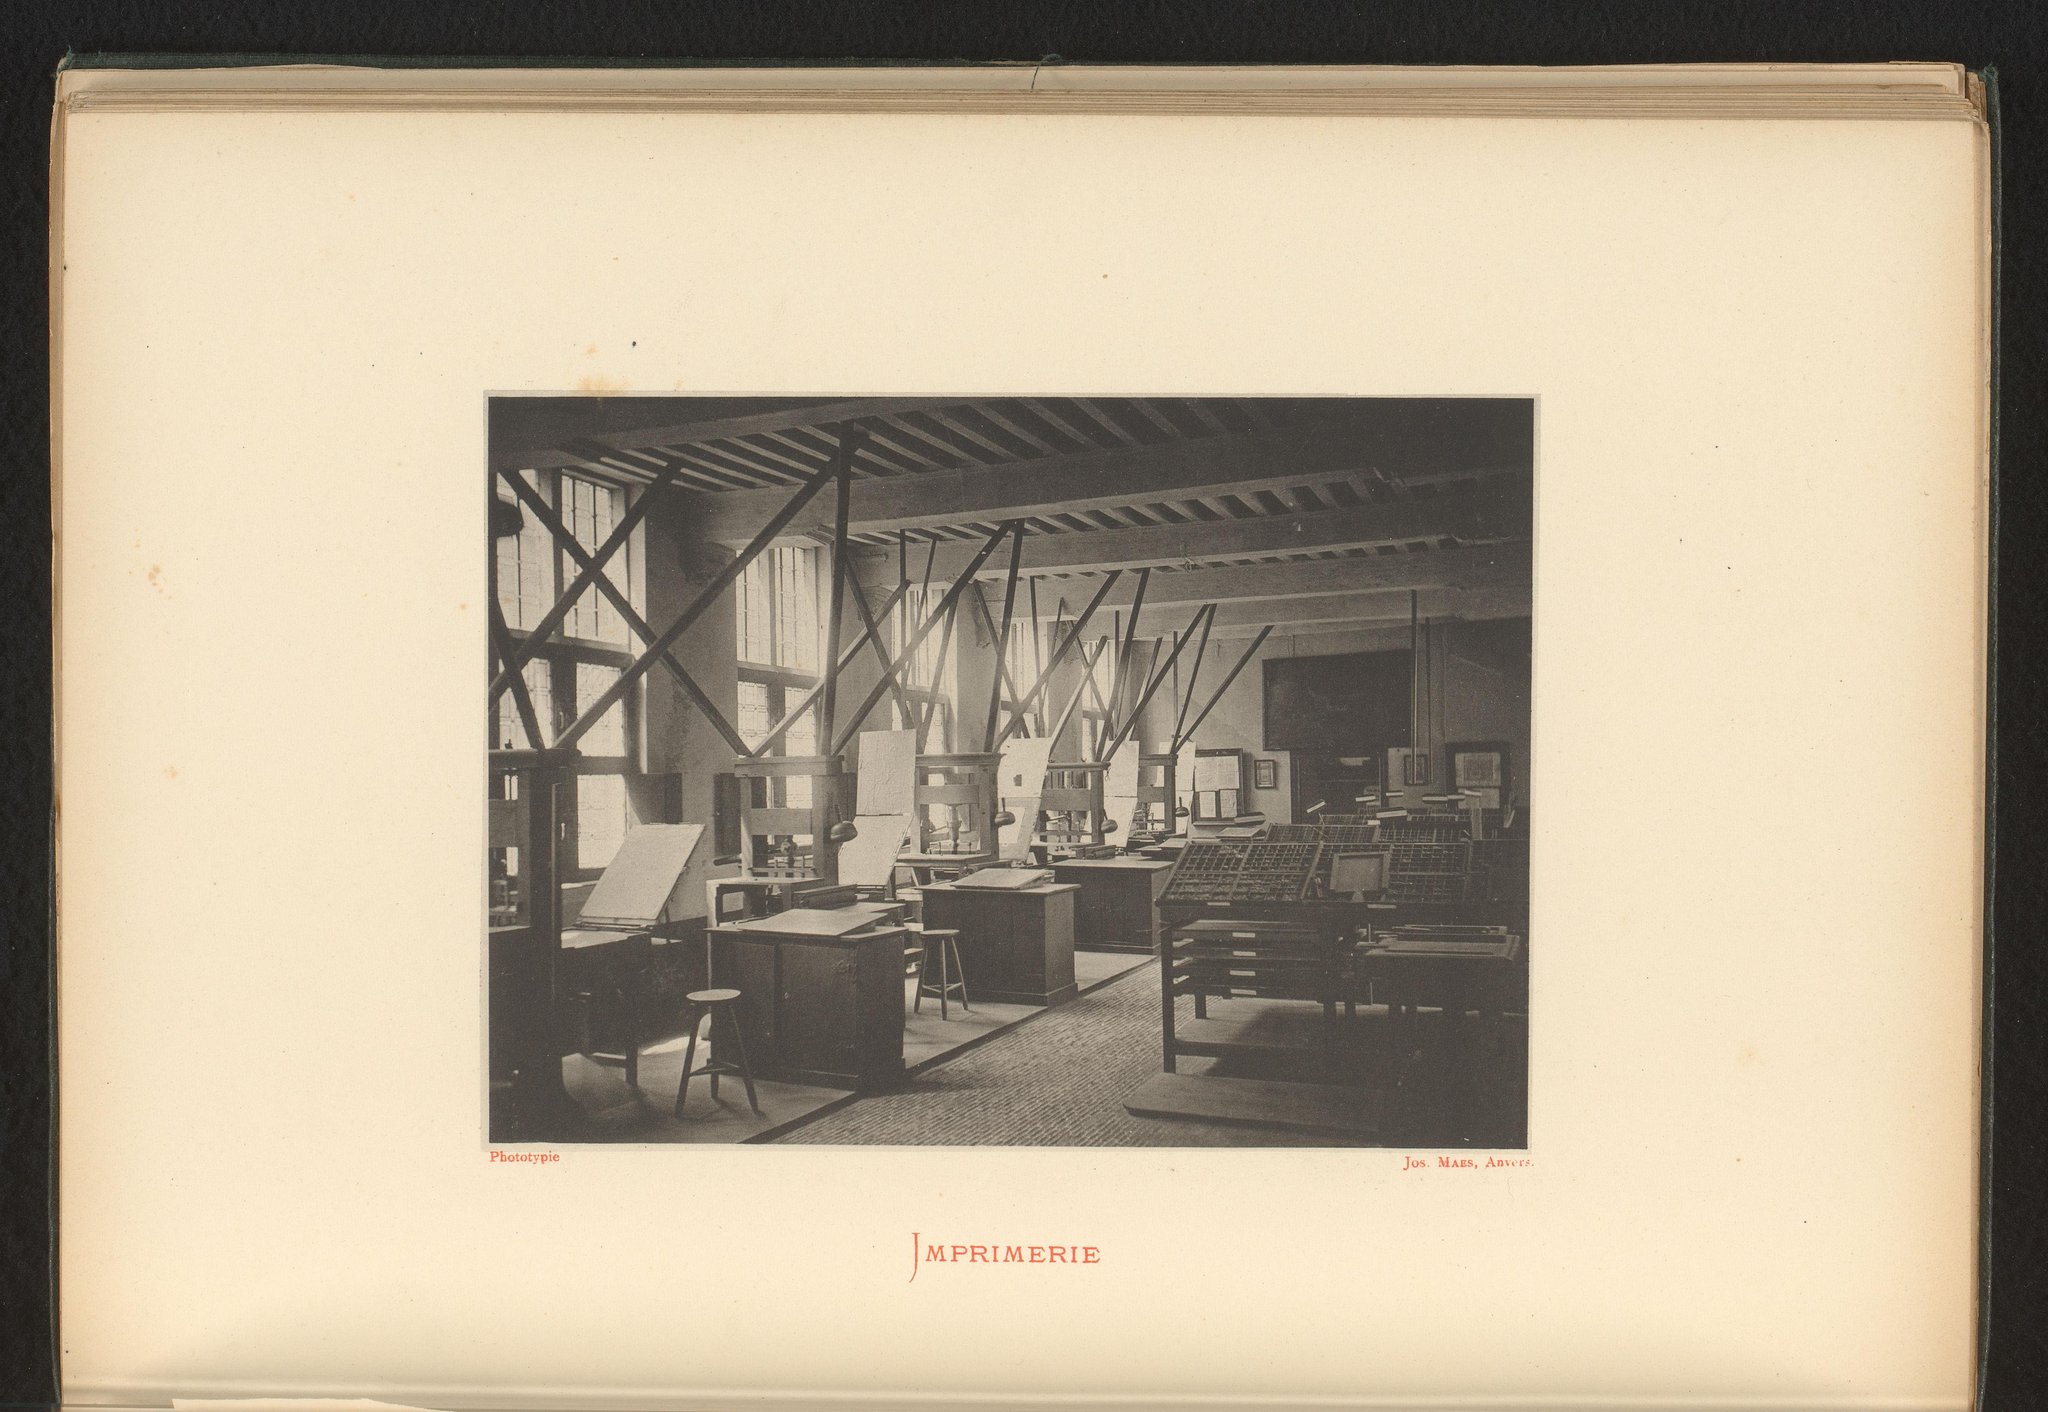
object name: photomechanical print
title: Imprimerie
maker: joseph maes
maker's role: fotograaf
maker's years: 1838-1908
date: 1877-1882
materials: paper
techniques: photograph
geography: antwerp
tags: printing press